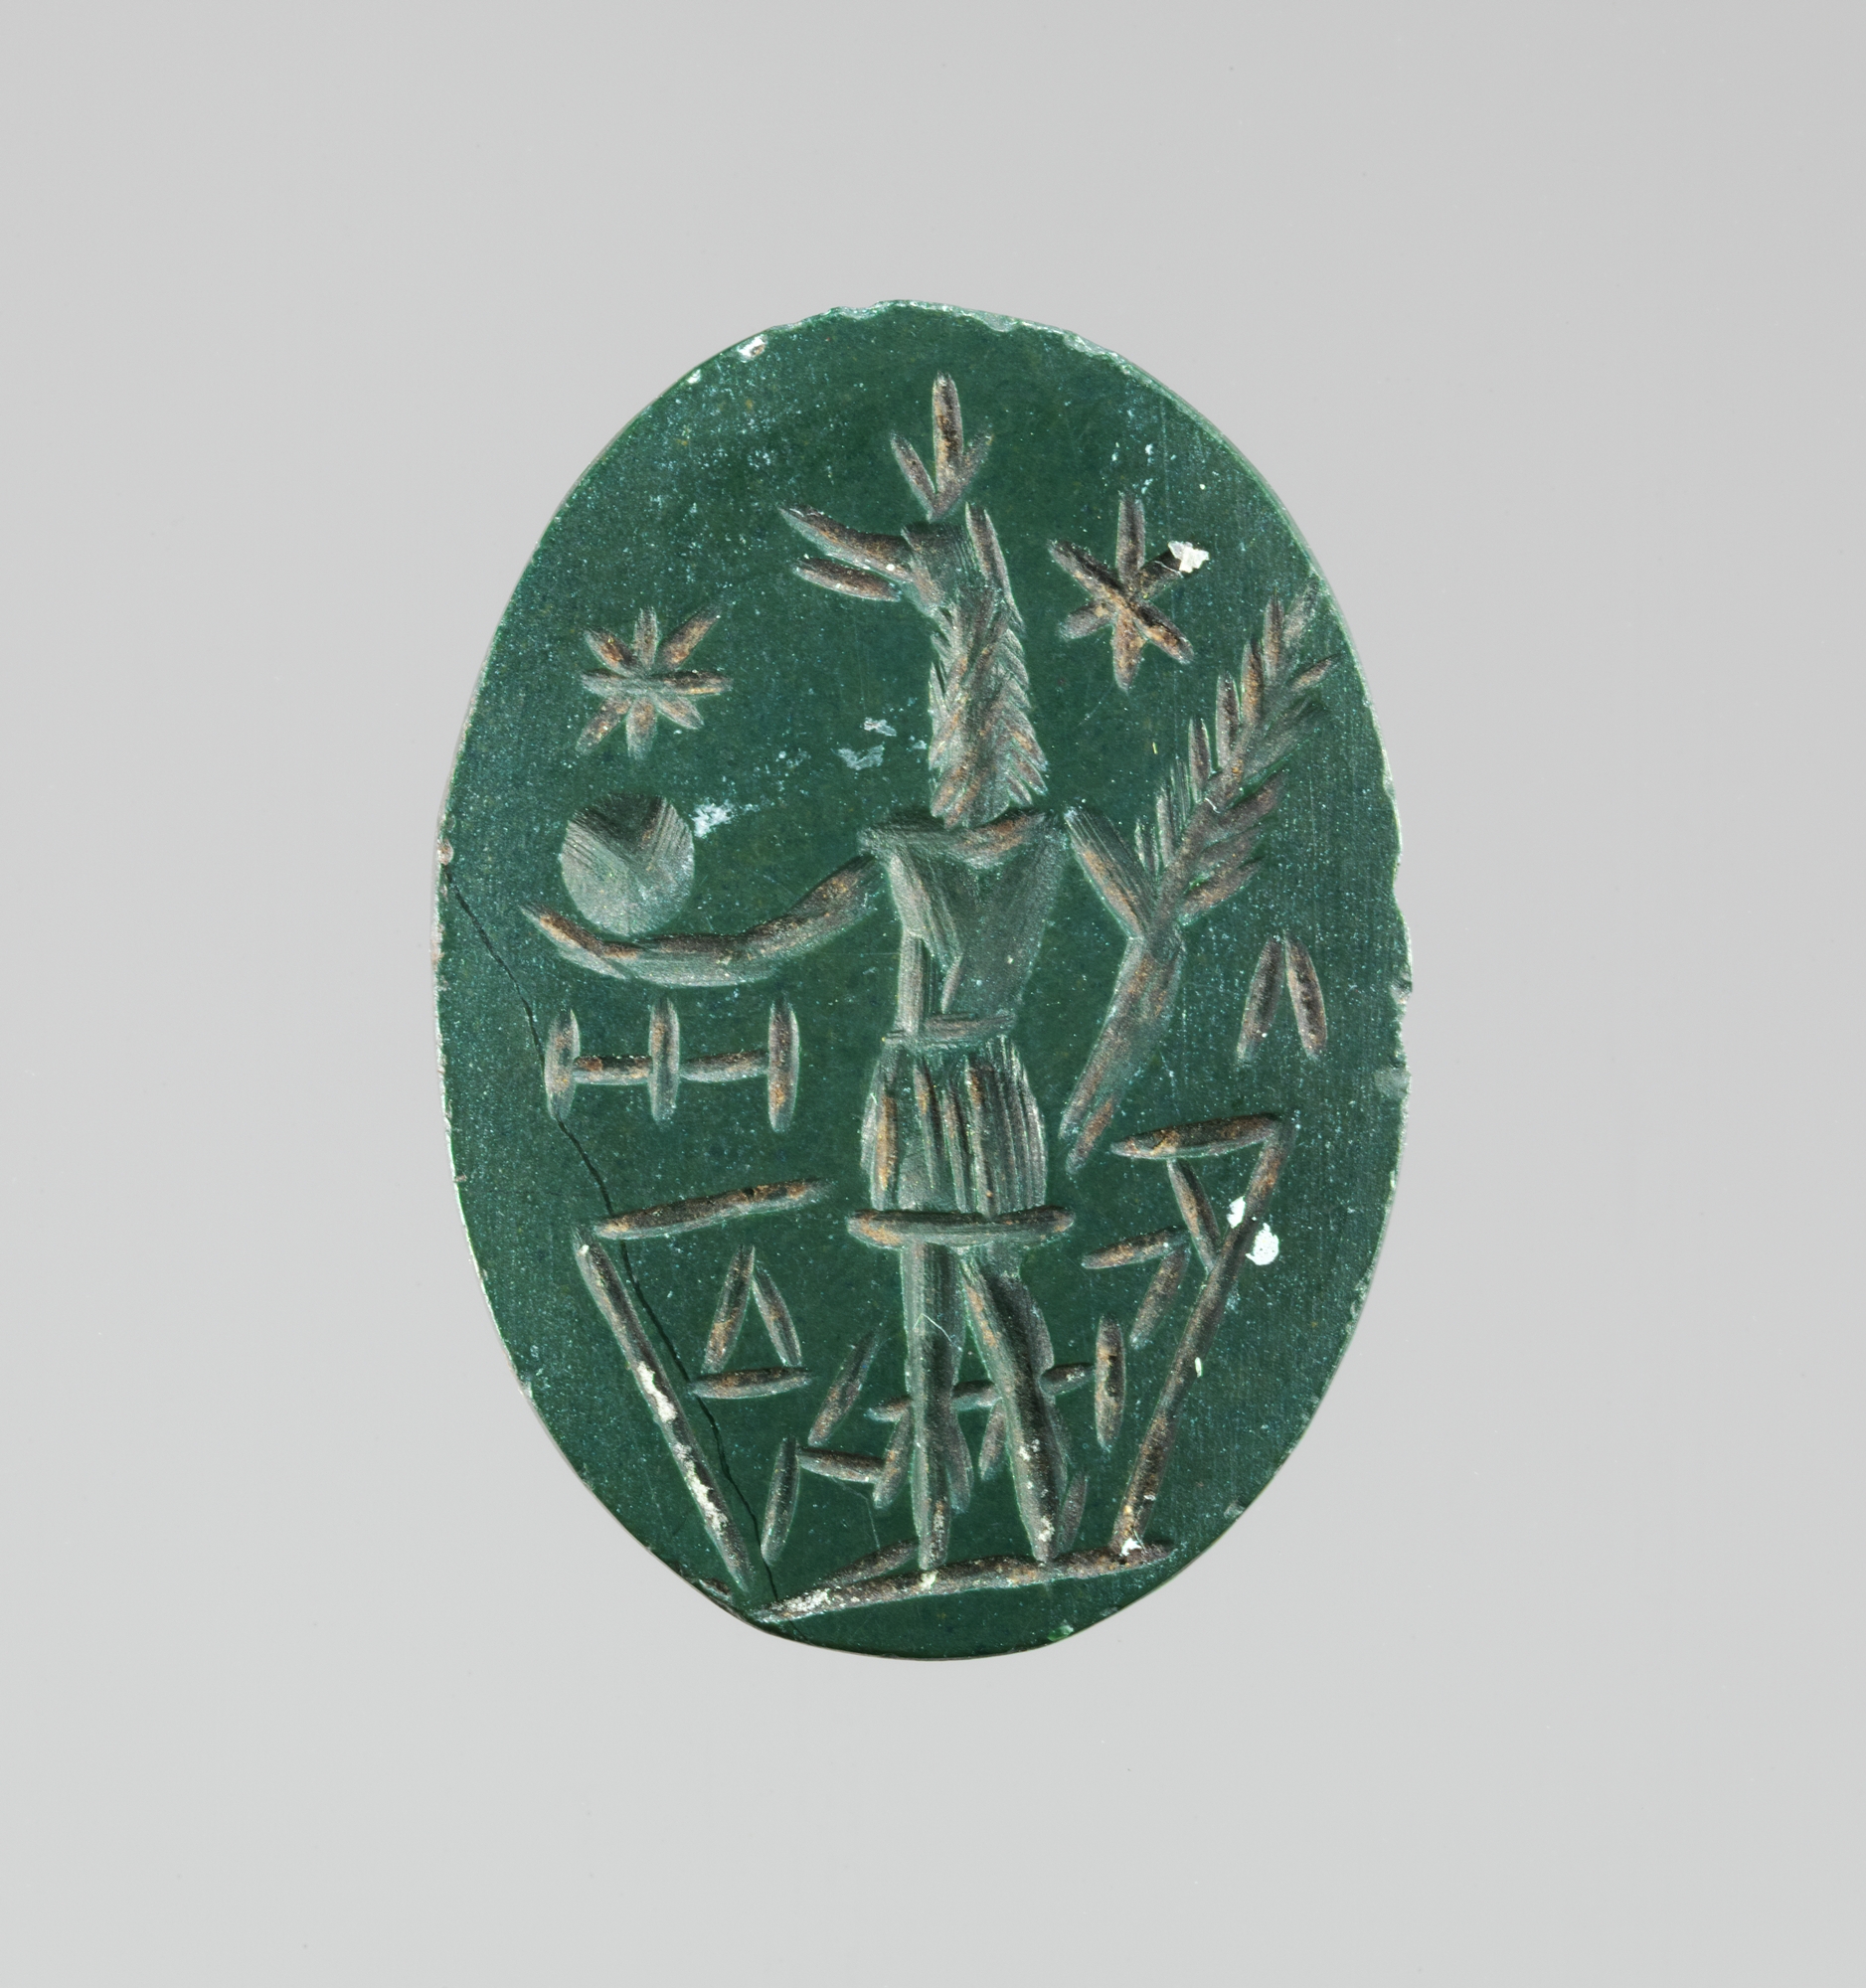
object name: intaglio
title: Jasper intaglio: Standing Anubis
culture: roman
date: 101-200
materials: jasper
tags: anubis